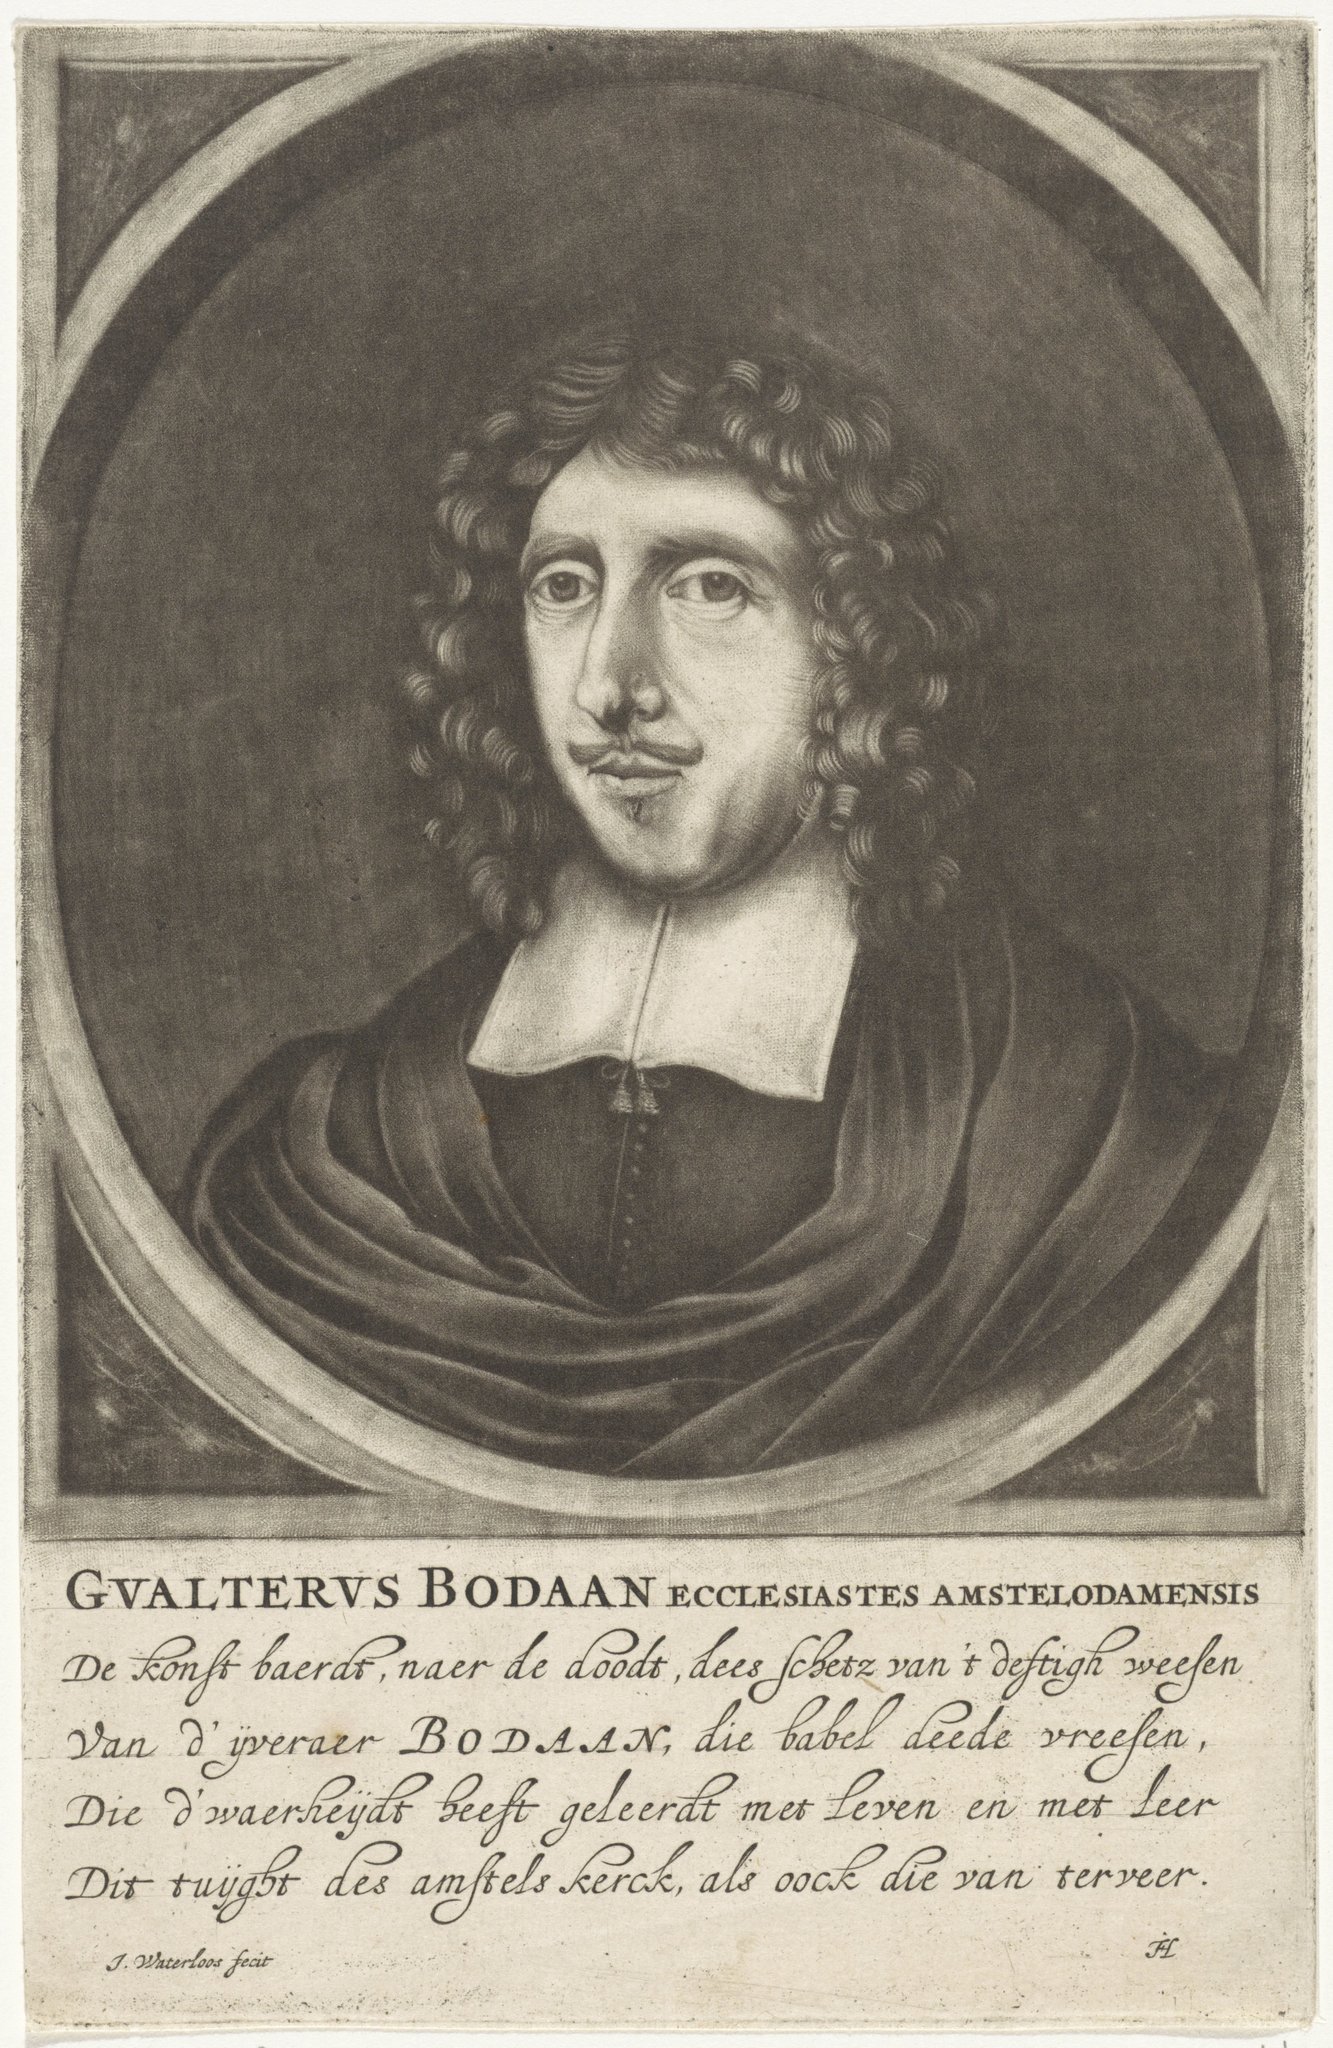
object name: print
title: Portret van de predikant Gualterus Bodaan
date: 1680-1684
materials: paper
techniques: engraving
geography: amsterdam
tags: amsterdam